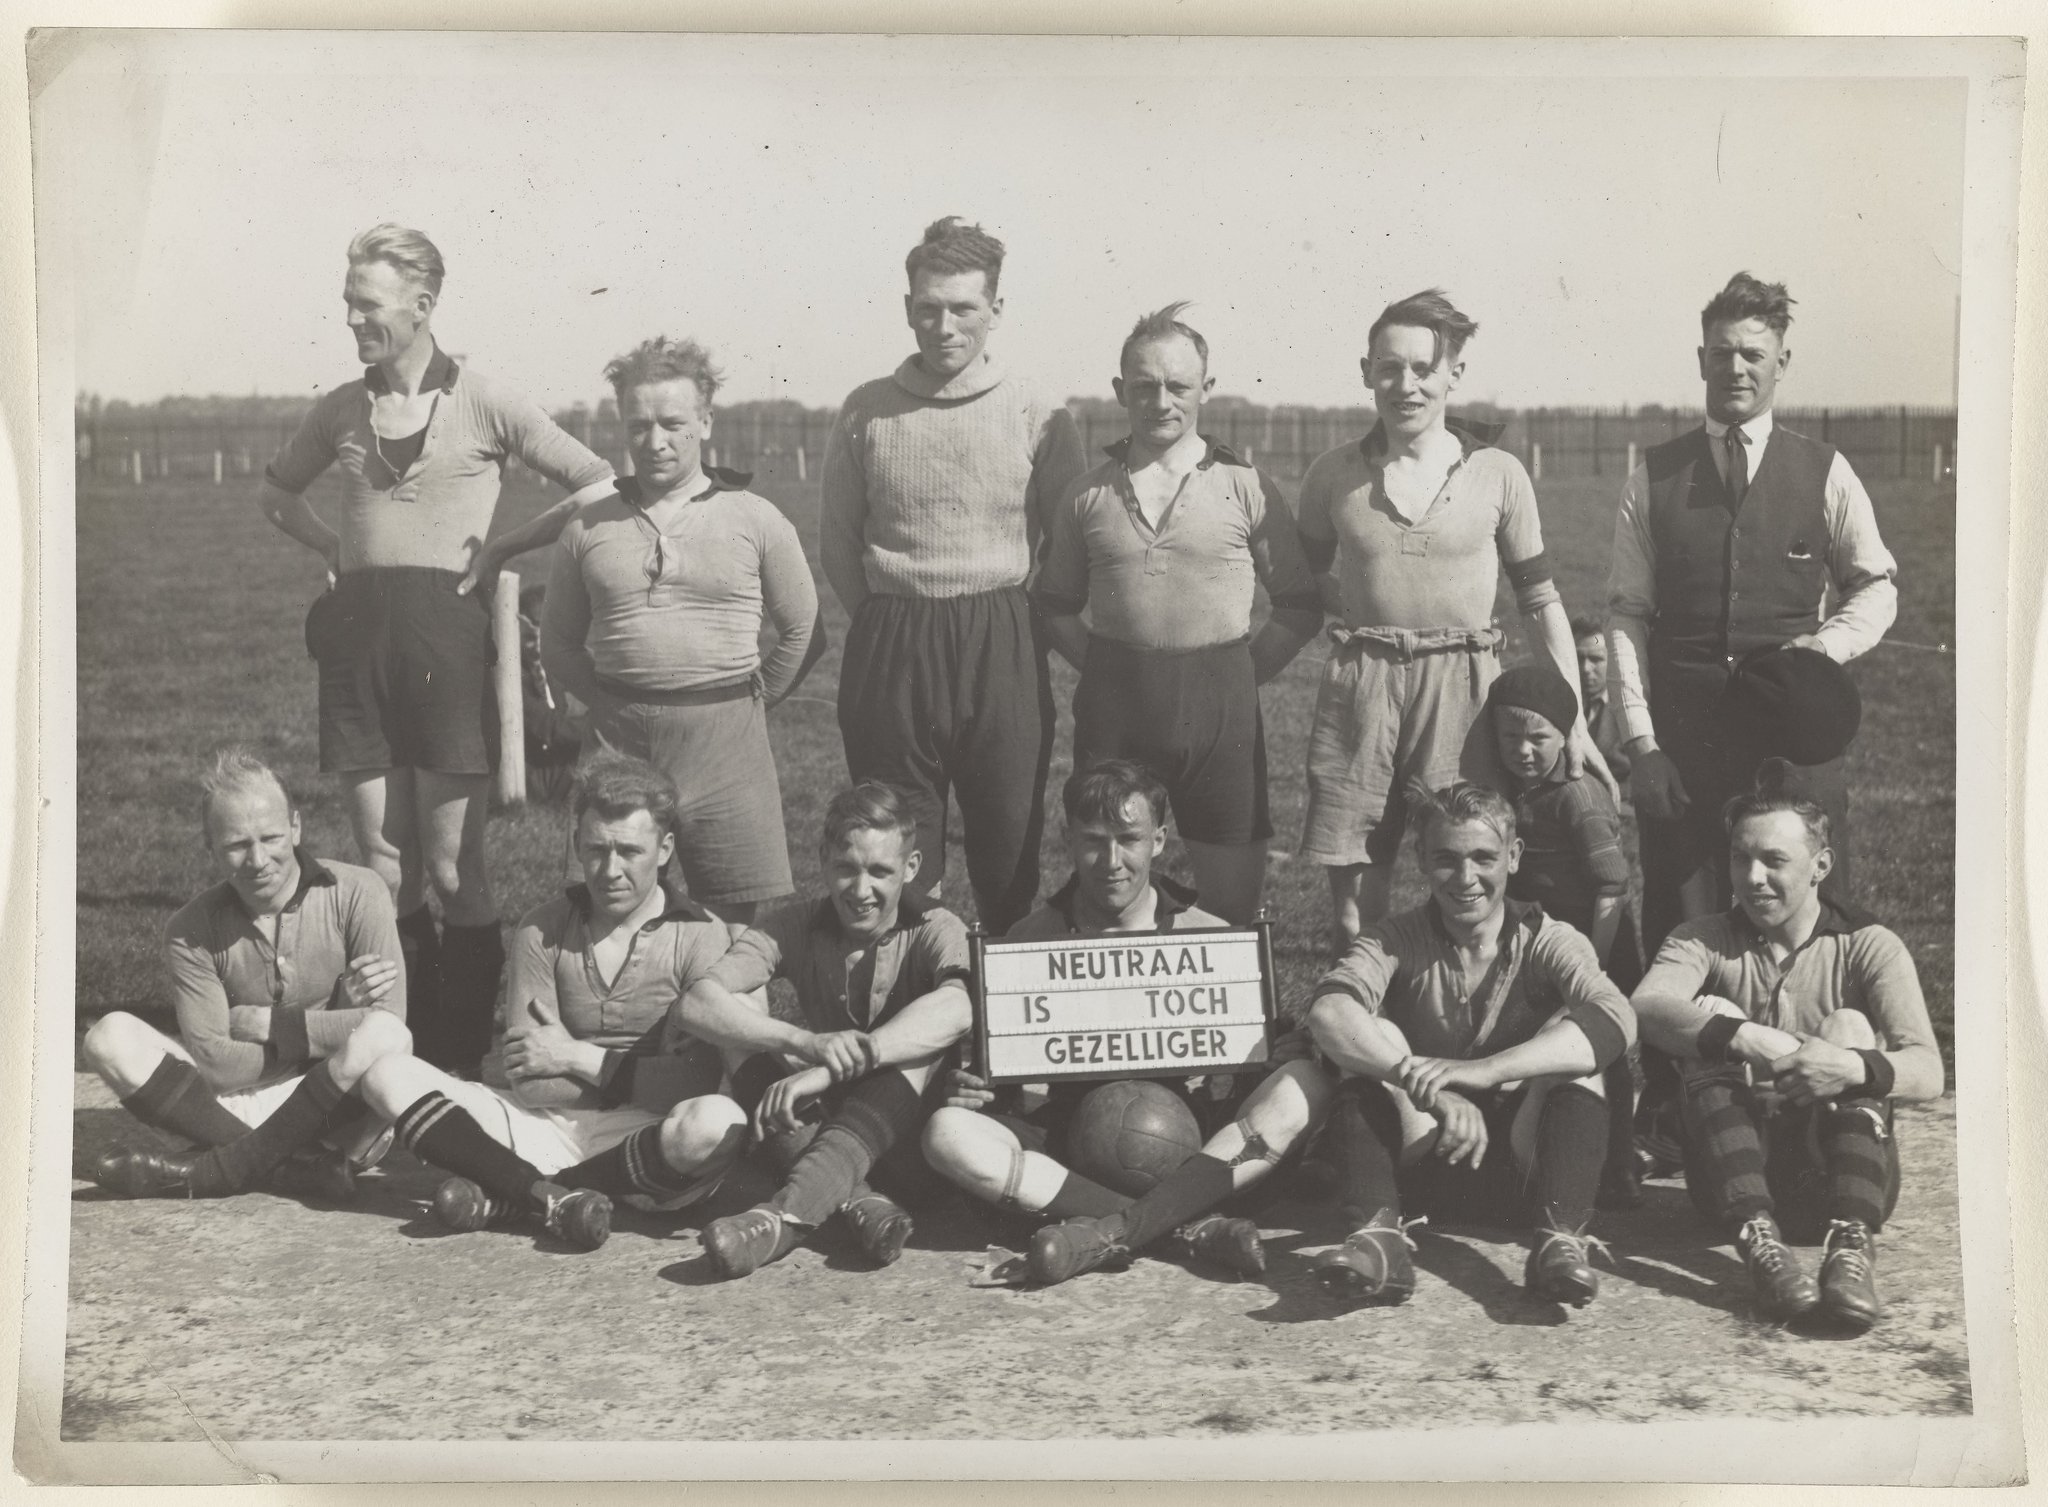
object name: photograph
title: Voetbalclub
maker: Anonymous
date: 1925-1940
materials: photographic support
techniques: photography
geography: netherlands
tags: netherlands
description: Groep mannen en jongens, 12 in totaal, in shirtjes en korte broeken met voetbalschoenen aan. Een heeft een bord vast:" Neutraal is toch gezelliger".